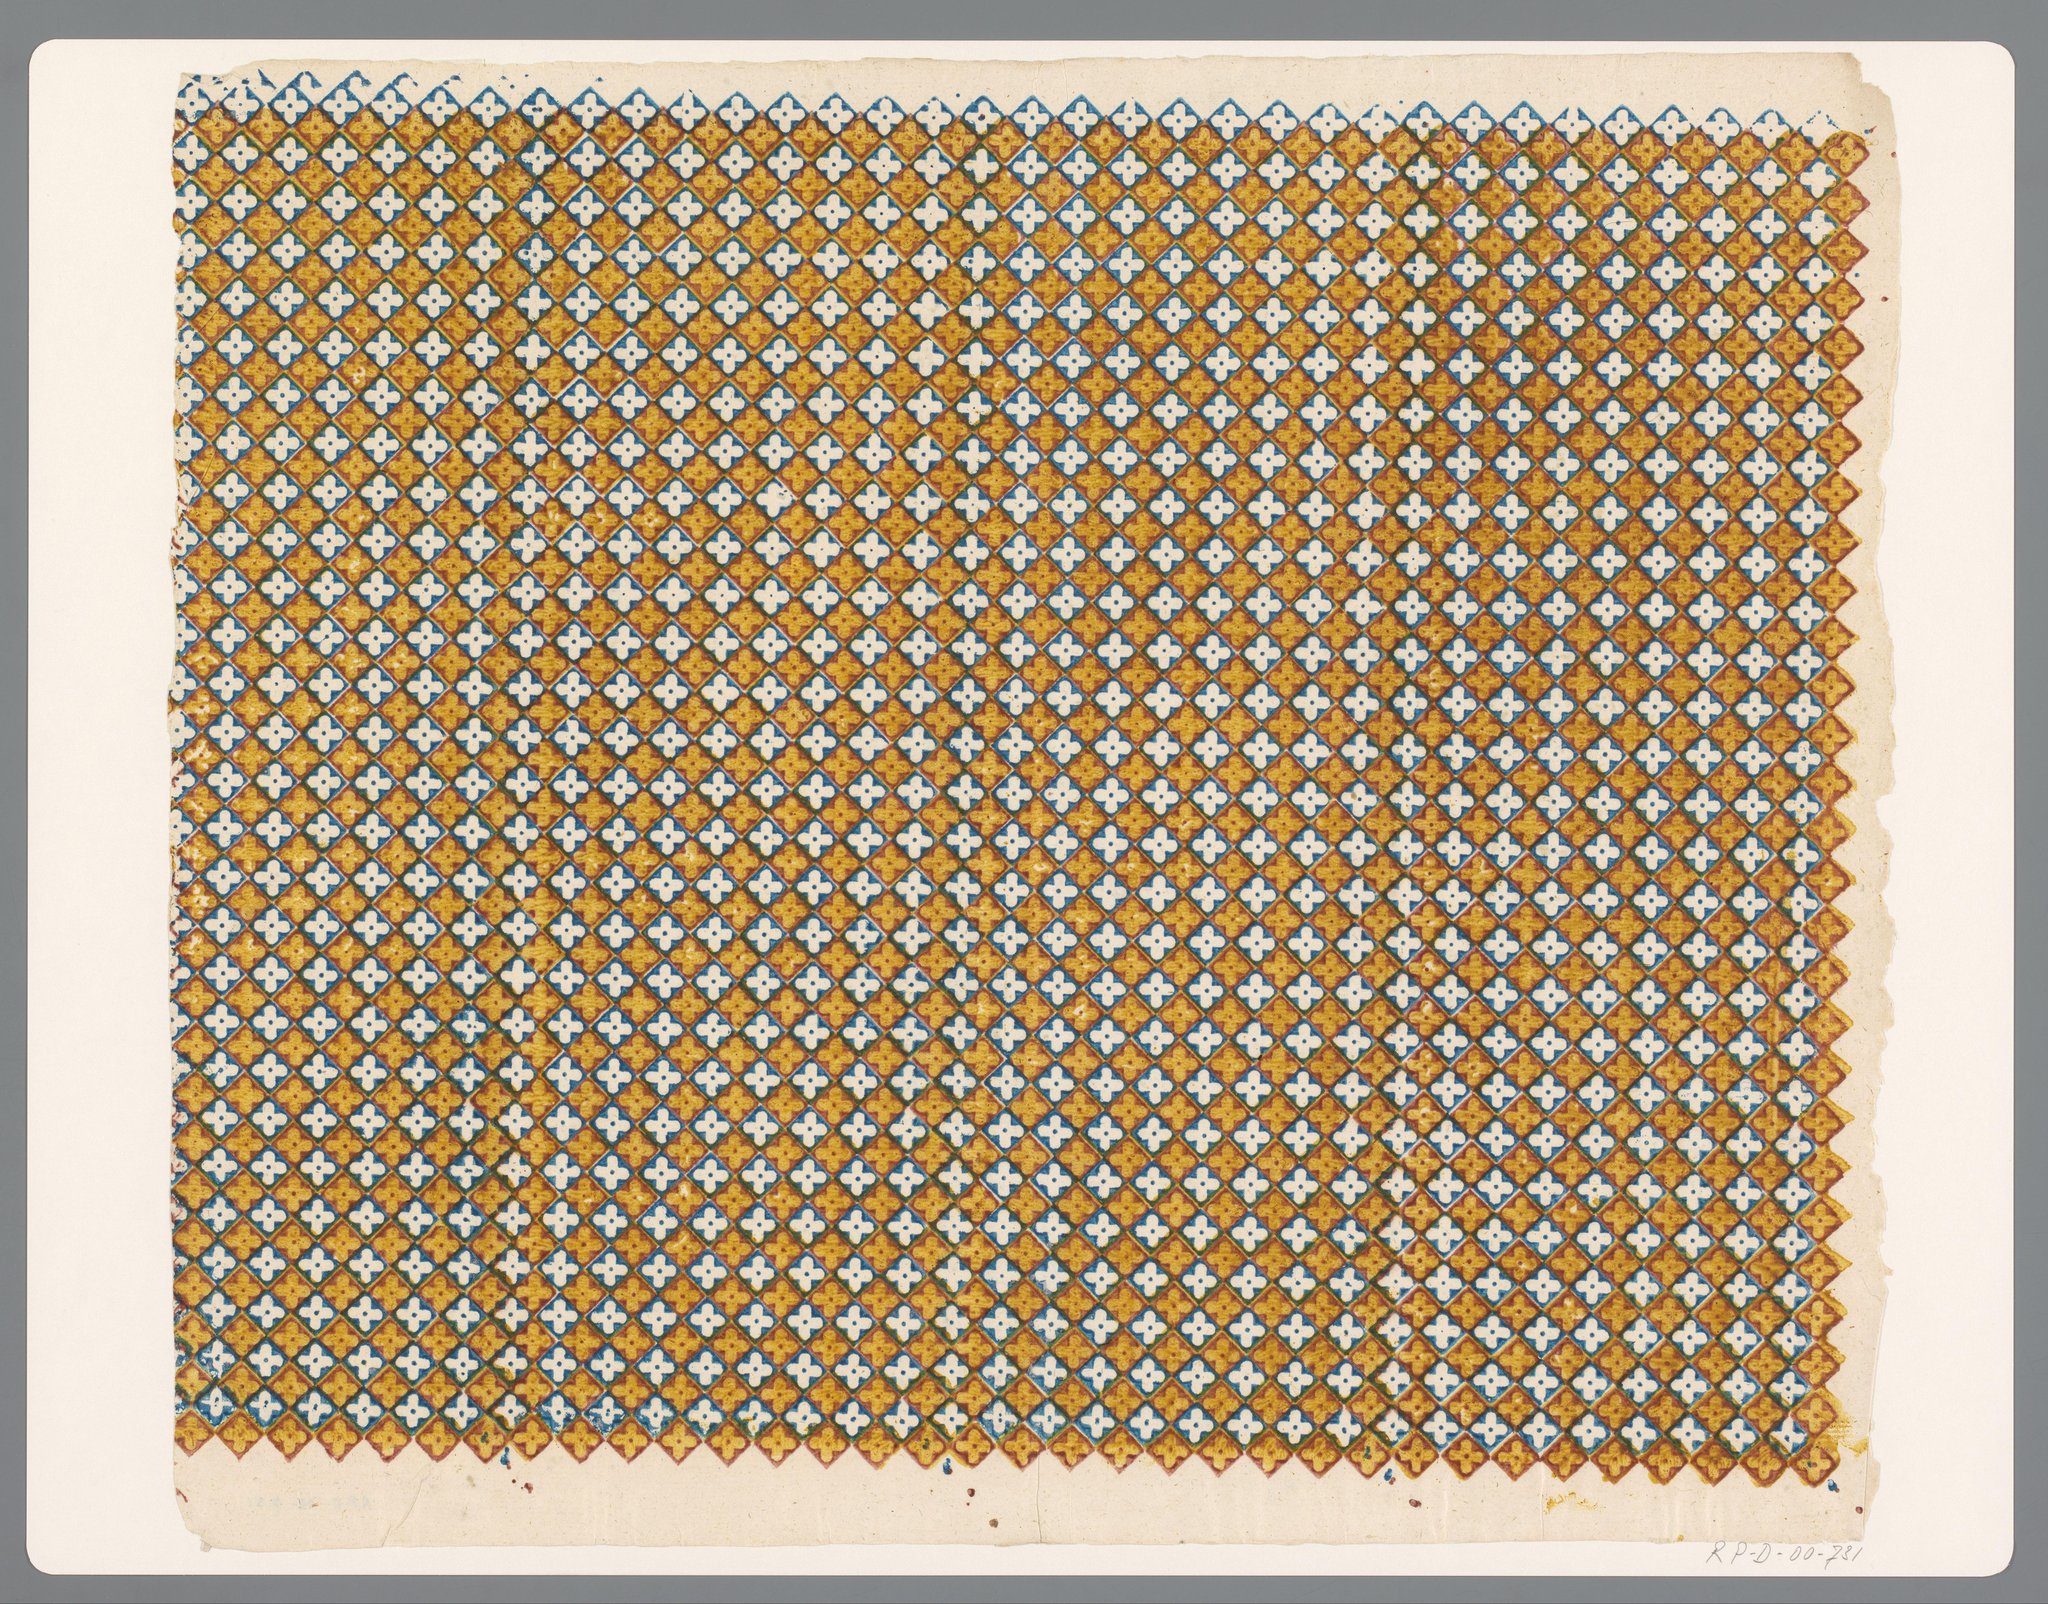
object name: printed paper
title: Blad met ruitenpatroon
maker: Anonymous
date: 1750-1900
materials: paper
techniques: printing block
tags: ornament derived from plant forms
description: Blad met ruitenpatroon met vierbladig bloemmotief als veldvulling.